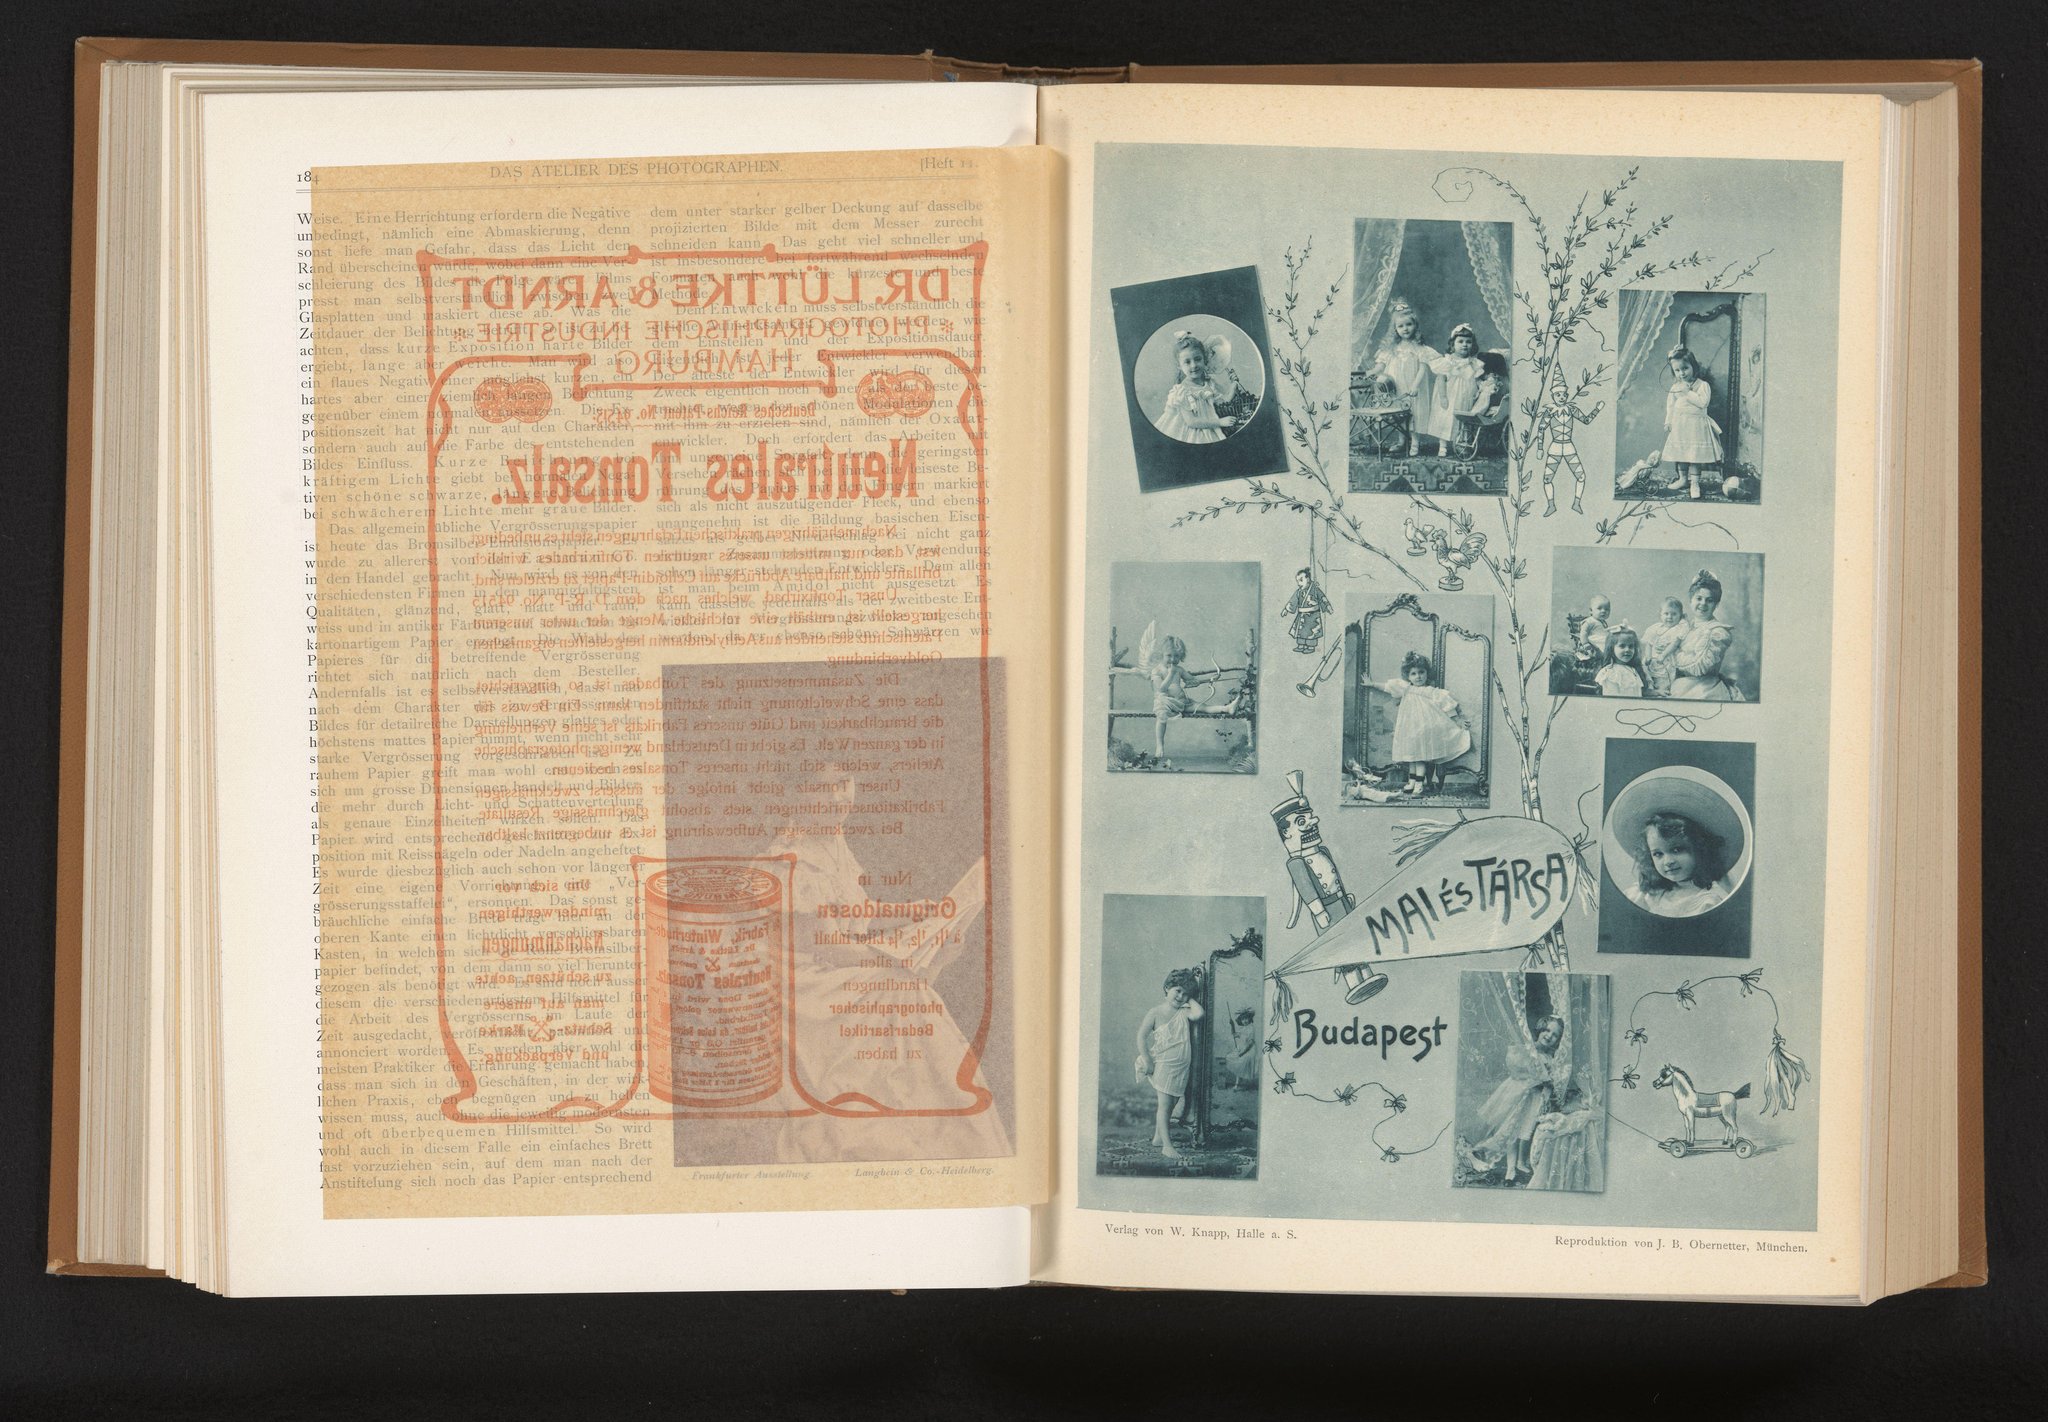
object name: page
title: Collage van portretten van onbekende kinderen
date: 1895-1900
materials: paper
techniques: photograph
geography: munich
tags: historical persons - bb - woman, historical persons